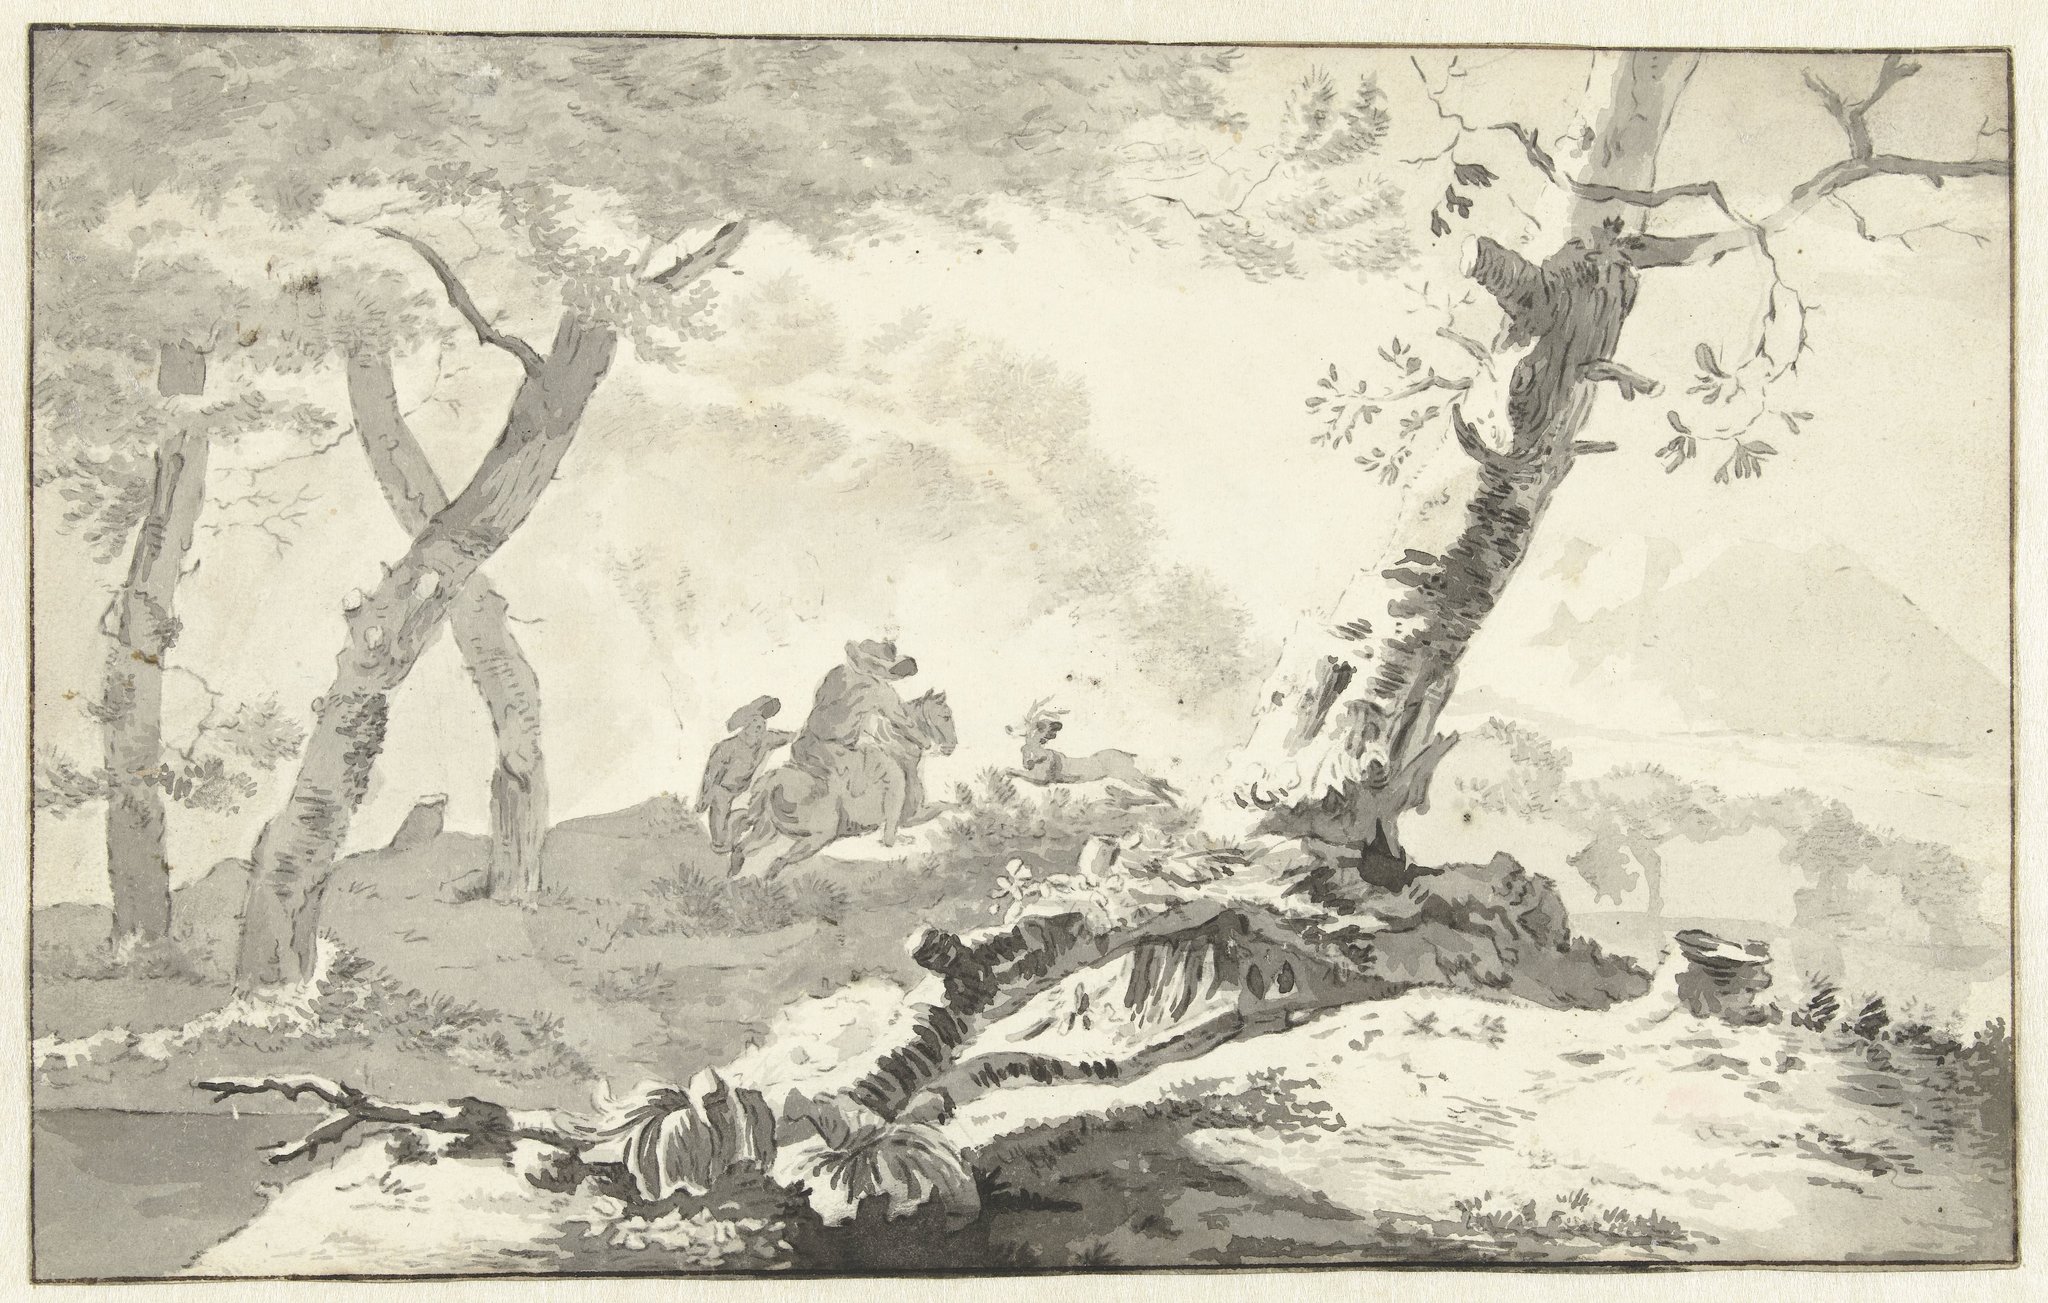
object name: drawing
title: Hertenjacht in een bergachtig landschap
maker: Anonymous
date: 1800-1898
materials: paper, pencil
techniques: brush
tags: low hill country, stag-hunting